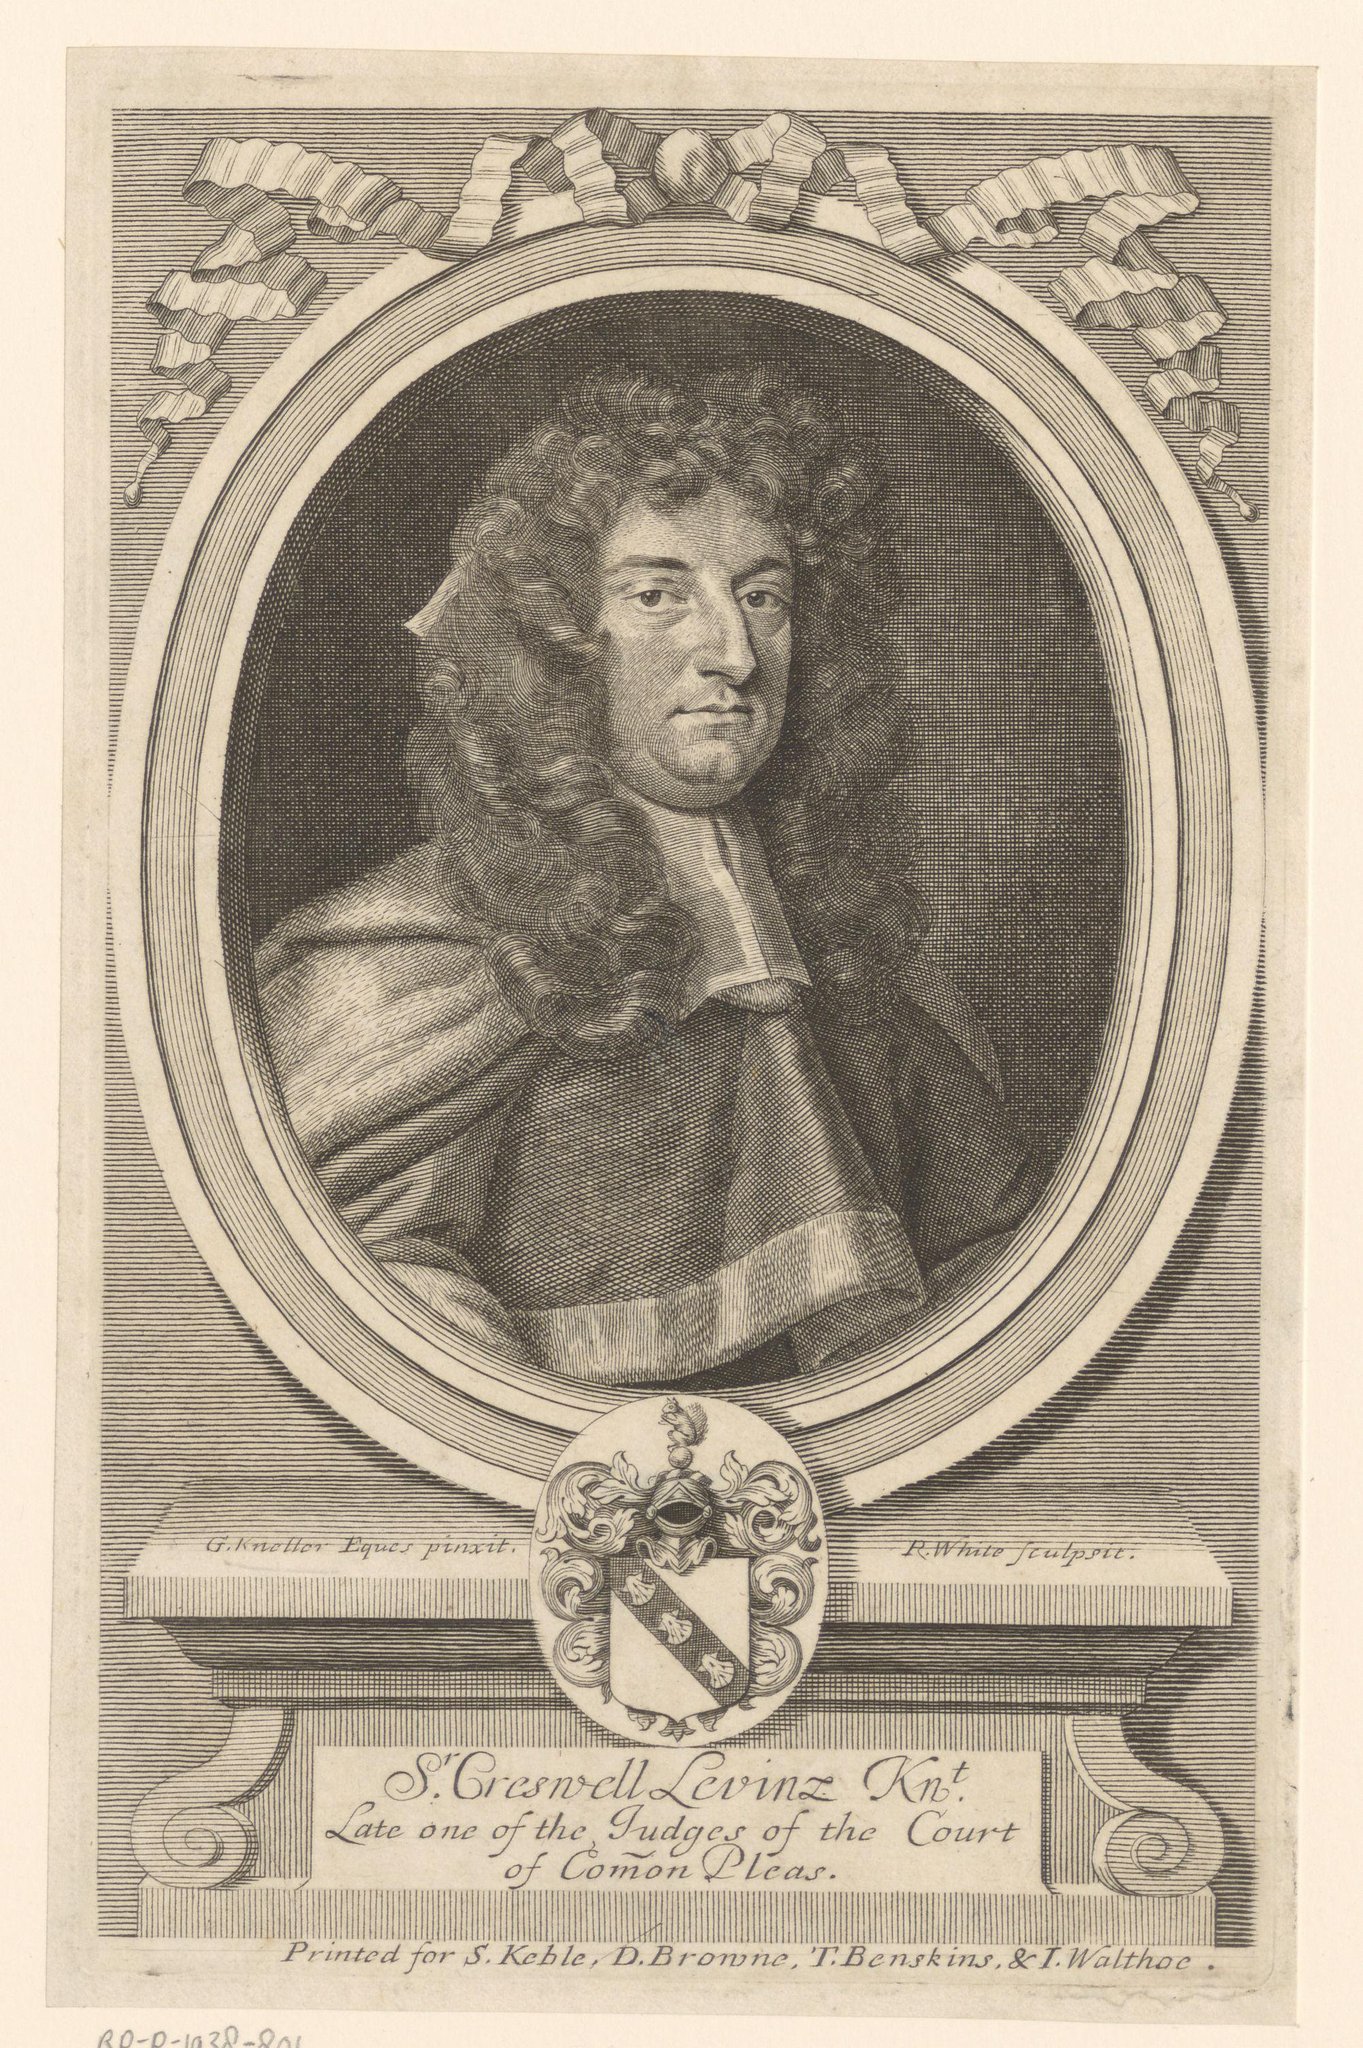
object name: print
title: Sr. Creswell Levinz Knt.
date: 1701-1703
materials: paper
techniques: engraving, etching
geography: london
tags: historical persons, magistracy, judges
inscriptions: collector's mark: Lugt 2228